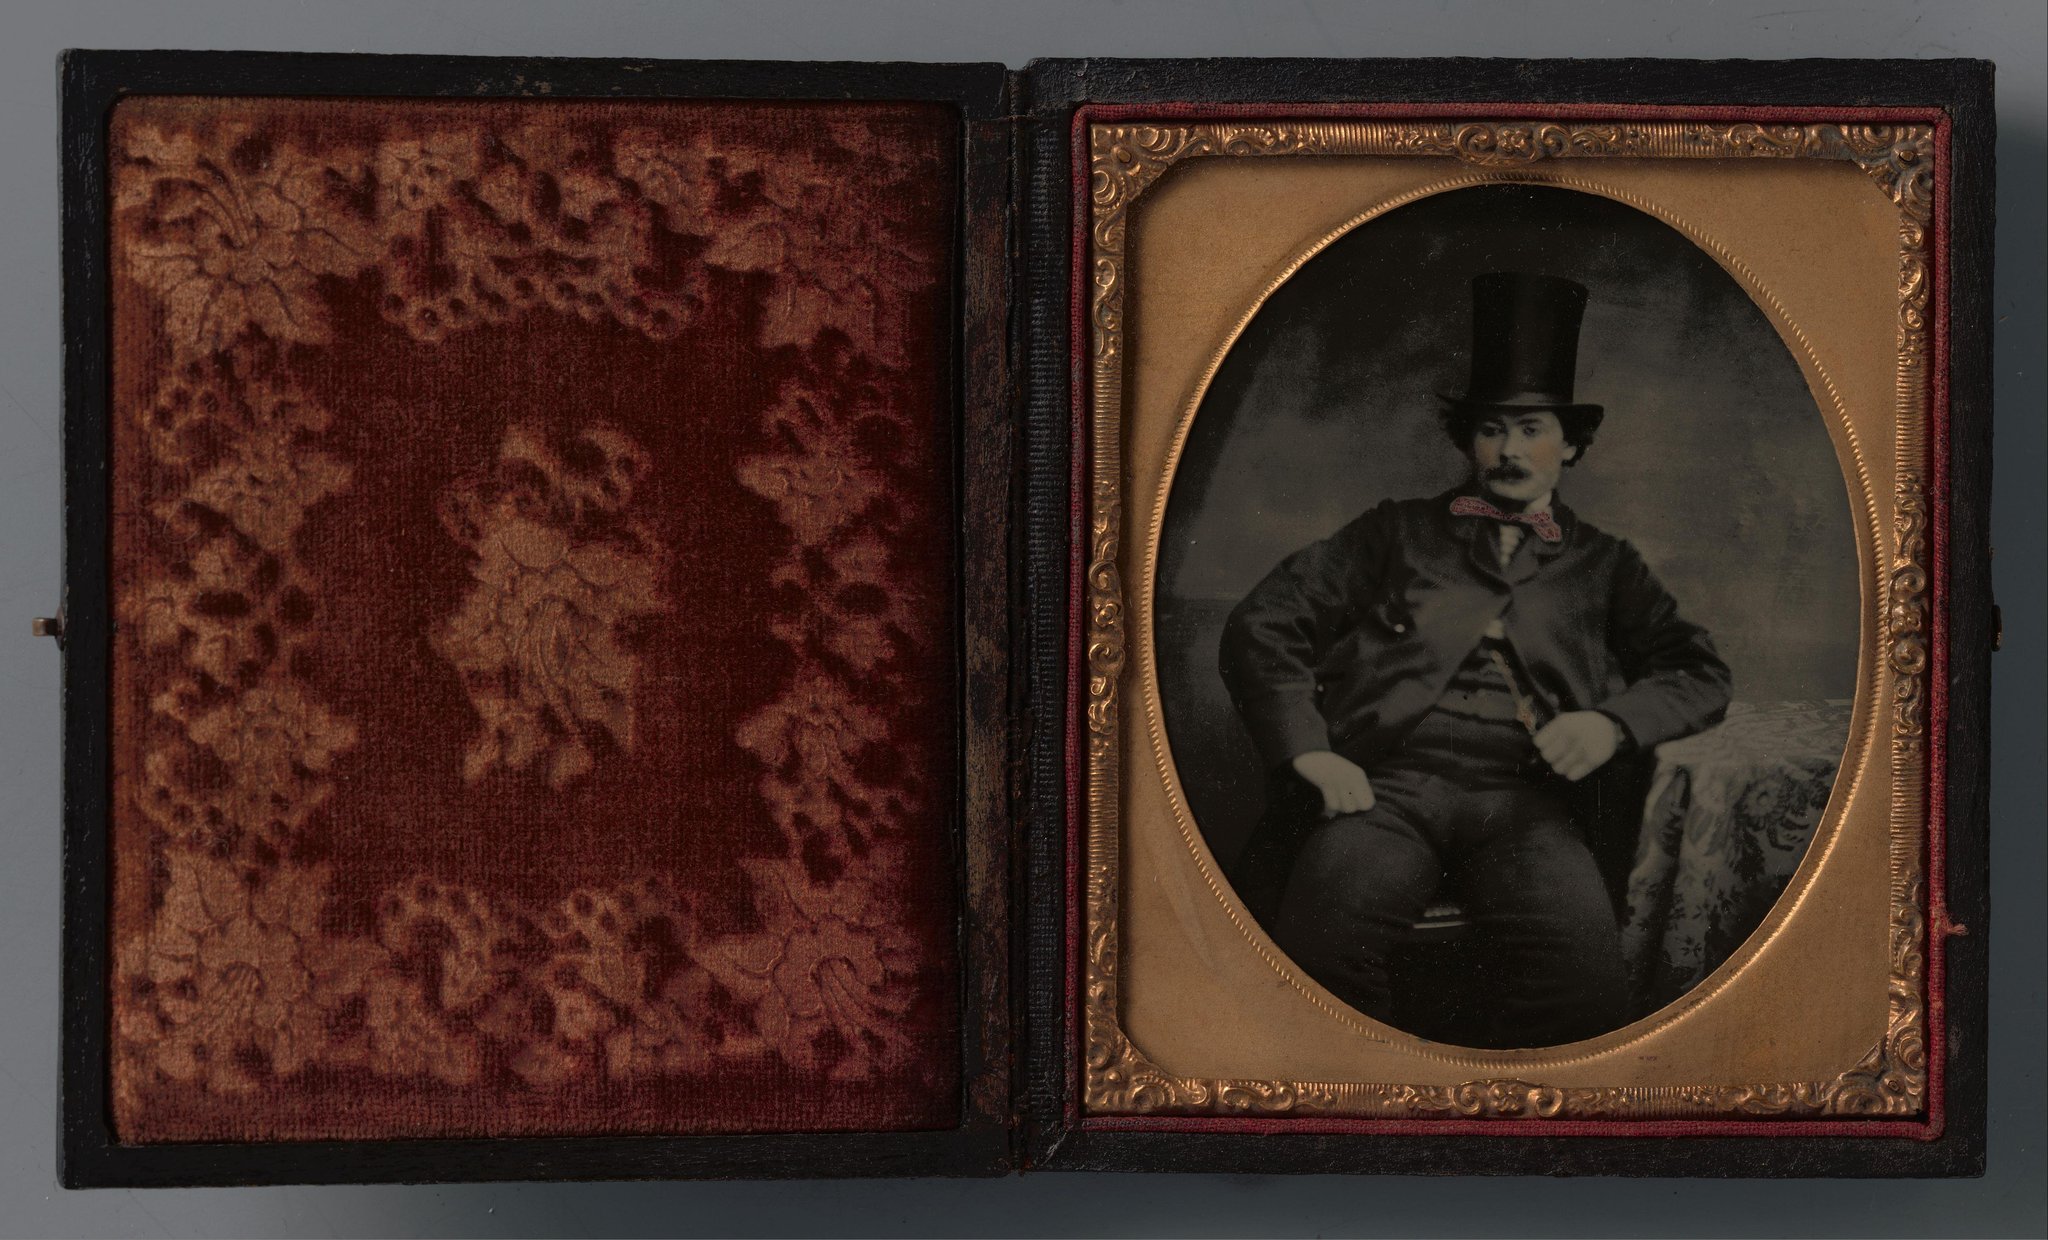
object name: photograph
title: Portret van een onbekende man met hoge hoed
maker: Anonymous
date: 1855-1870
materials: glass, metal, velvet, wood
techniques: ambrotype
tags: sitting figure, historical persons, head-gear: top hat